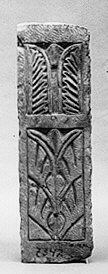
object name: pilaster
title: Pilaster with a Pattern of Leaves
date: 201-1200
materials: limestone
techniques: carving, relief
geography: egypt